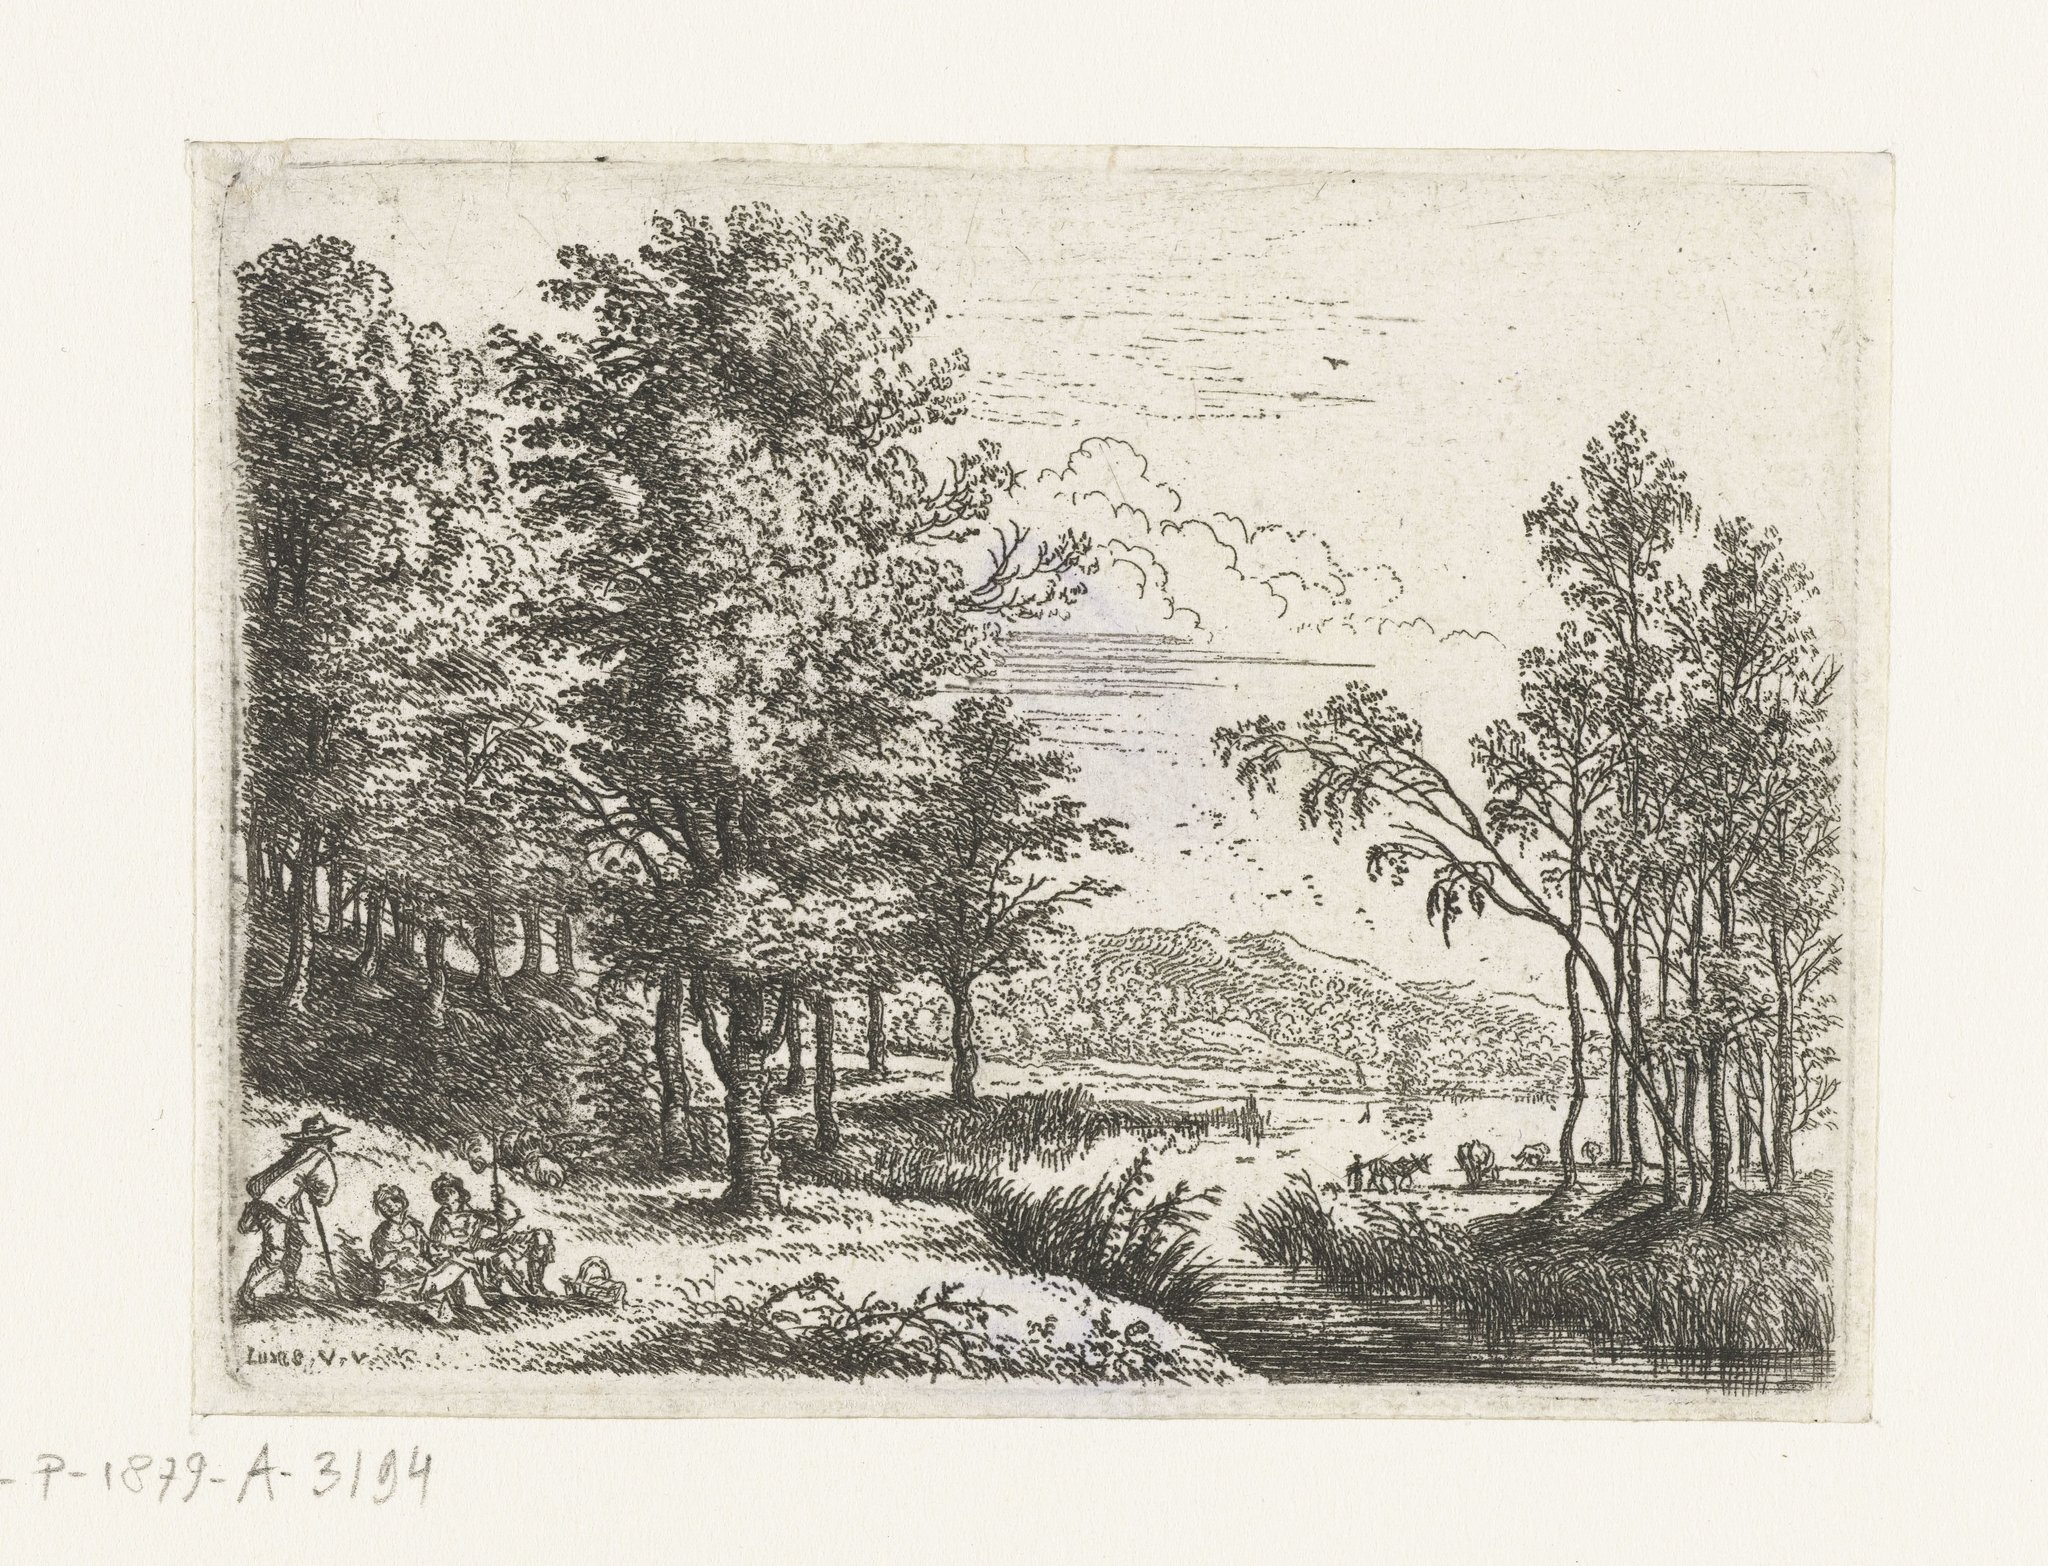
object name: print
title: Kleine landschappen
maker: lucas van uden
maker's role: draughtsman, print maker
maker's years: 1595-1673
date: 1605-1673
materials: paper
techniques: etching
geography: low countries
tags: the (nude) human figure; 'corpo humano' (ripa) (+ three persons), lake, picnic, alfresco, 'déjeuner sur l'herbe'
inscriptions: collector's mark: Lugt 2228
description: Uit een serie van twaalf. Landschap met twee mannen en een vrouw met een picknickmand bij de oever van een meer.